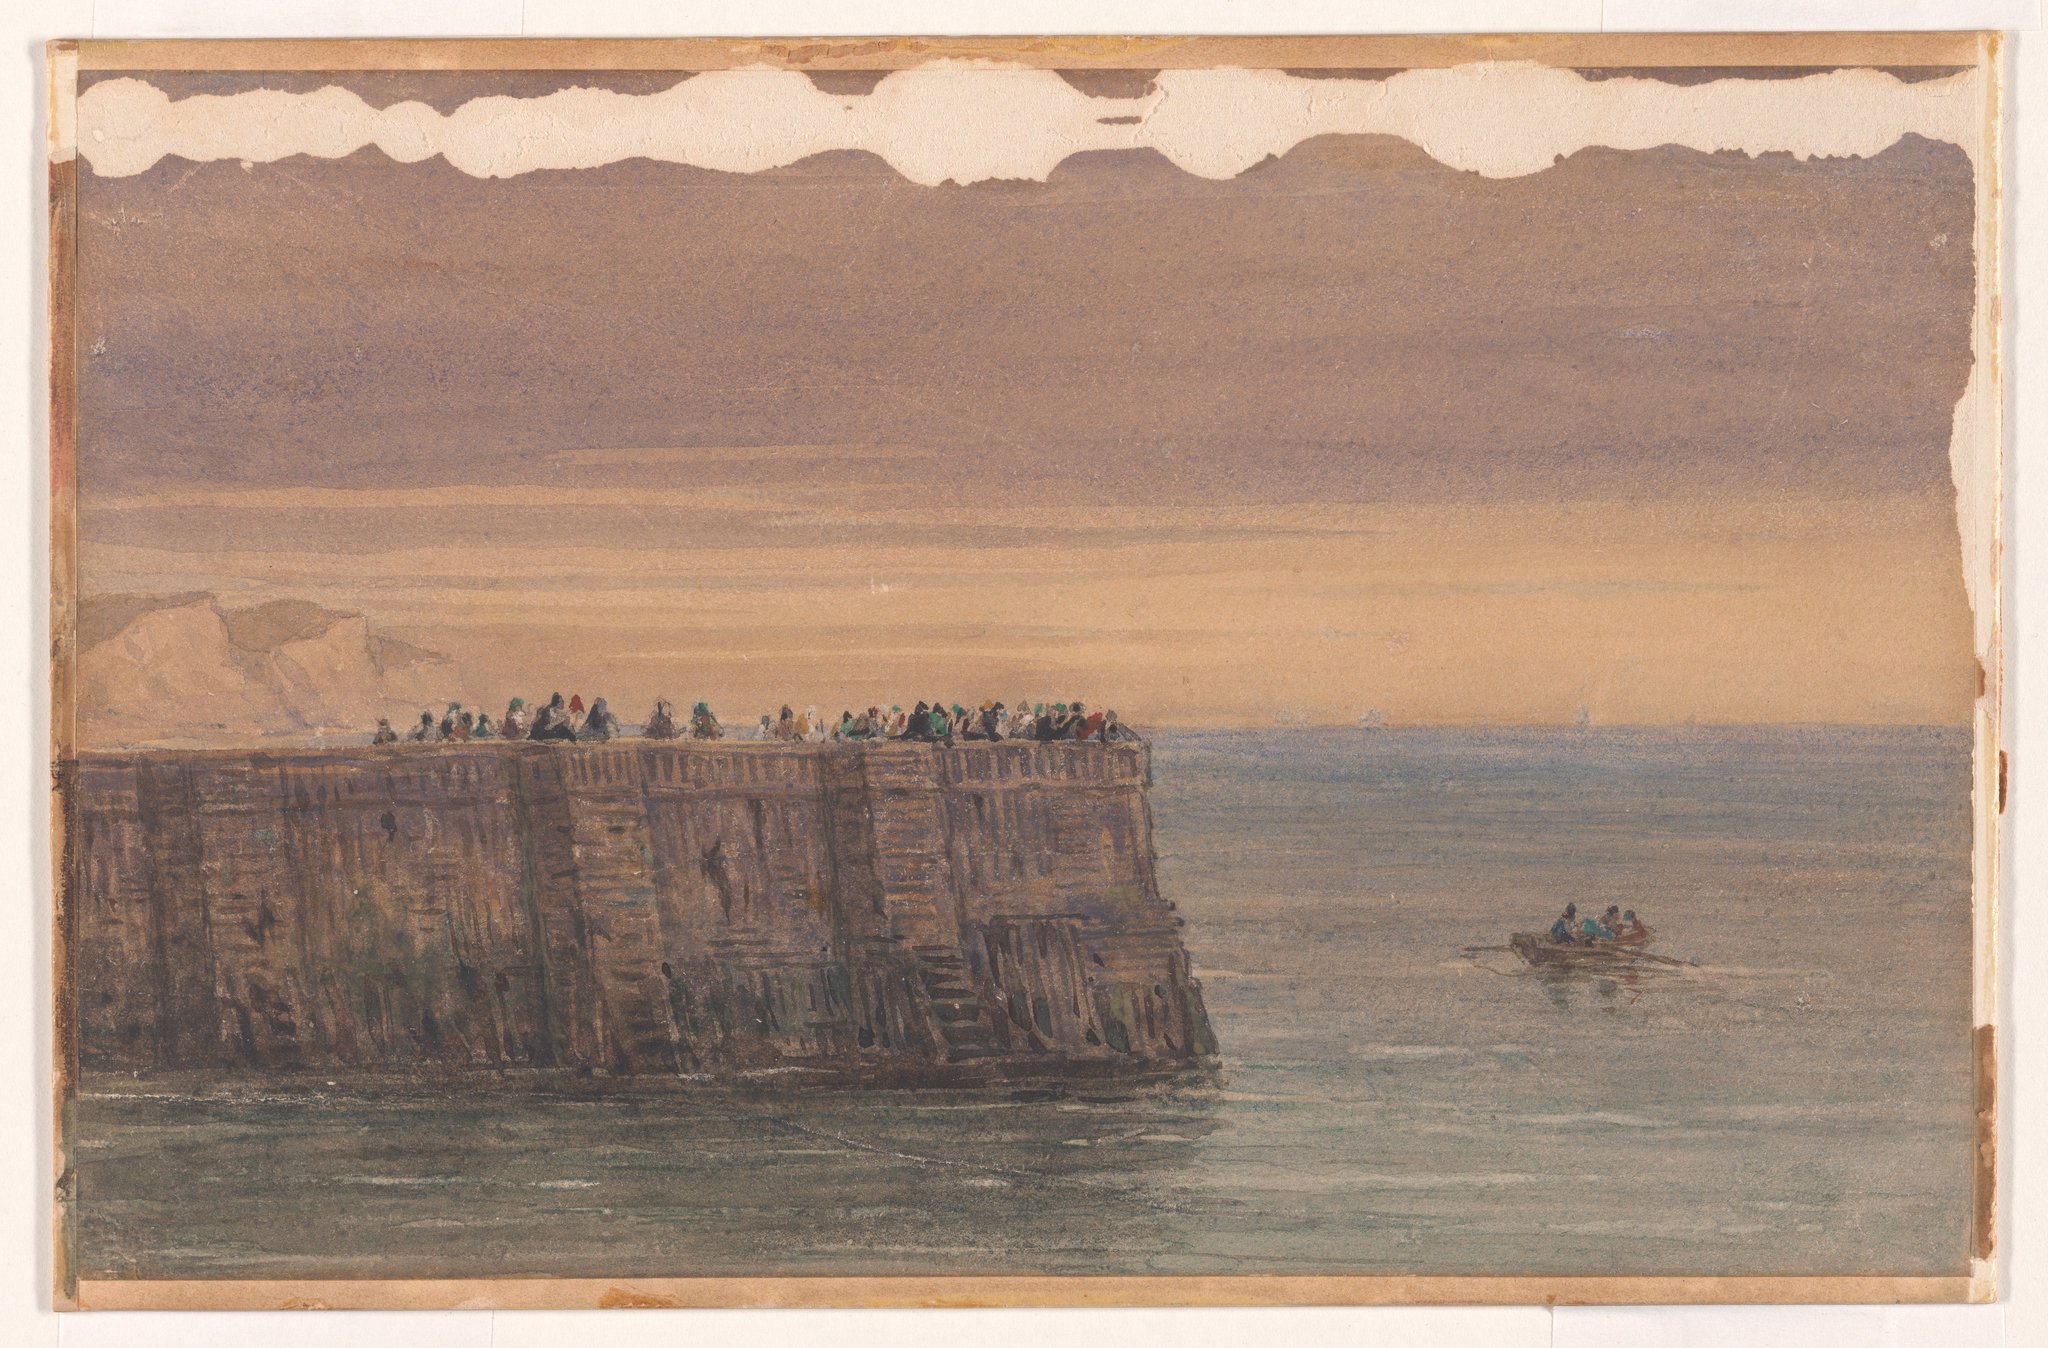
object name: drawing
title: Dover Pier, Kent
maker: david cox, the elder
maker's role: artist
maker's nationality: english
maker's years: 1783-1859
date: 1828-1840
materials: gouache, graphite, watercolor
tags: boats,piers